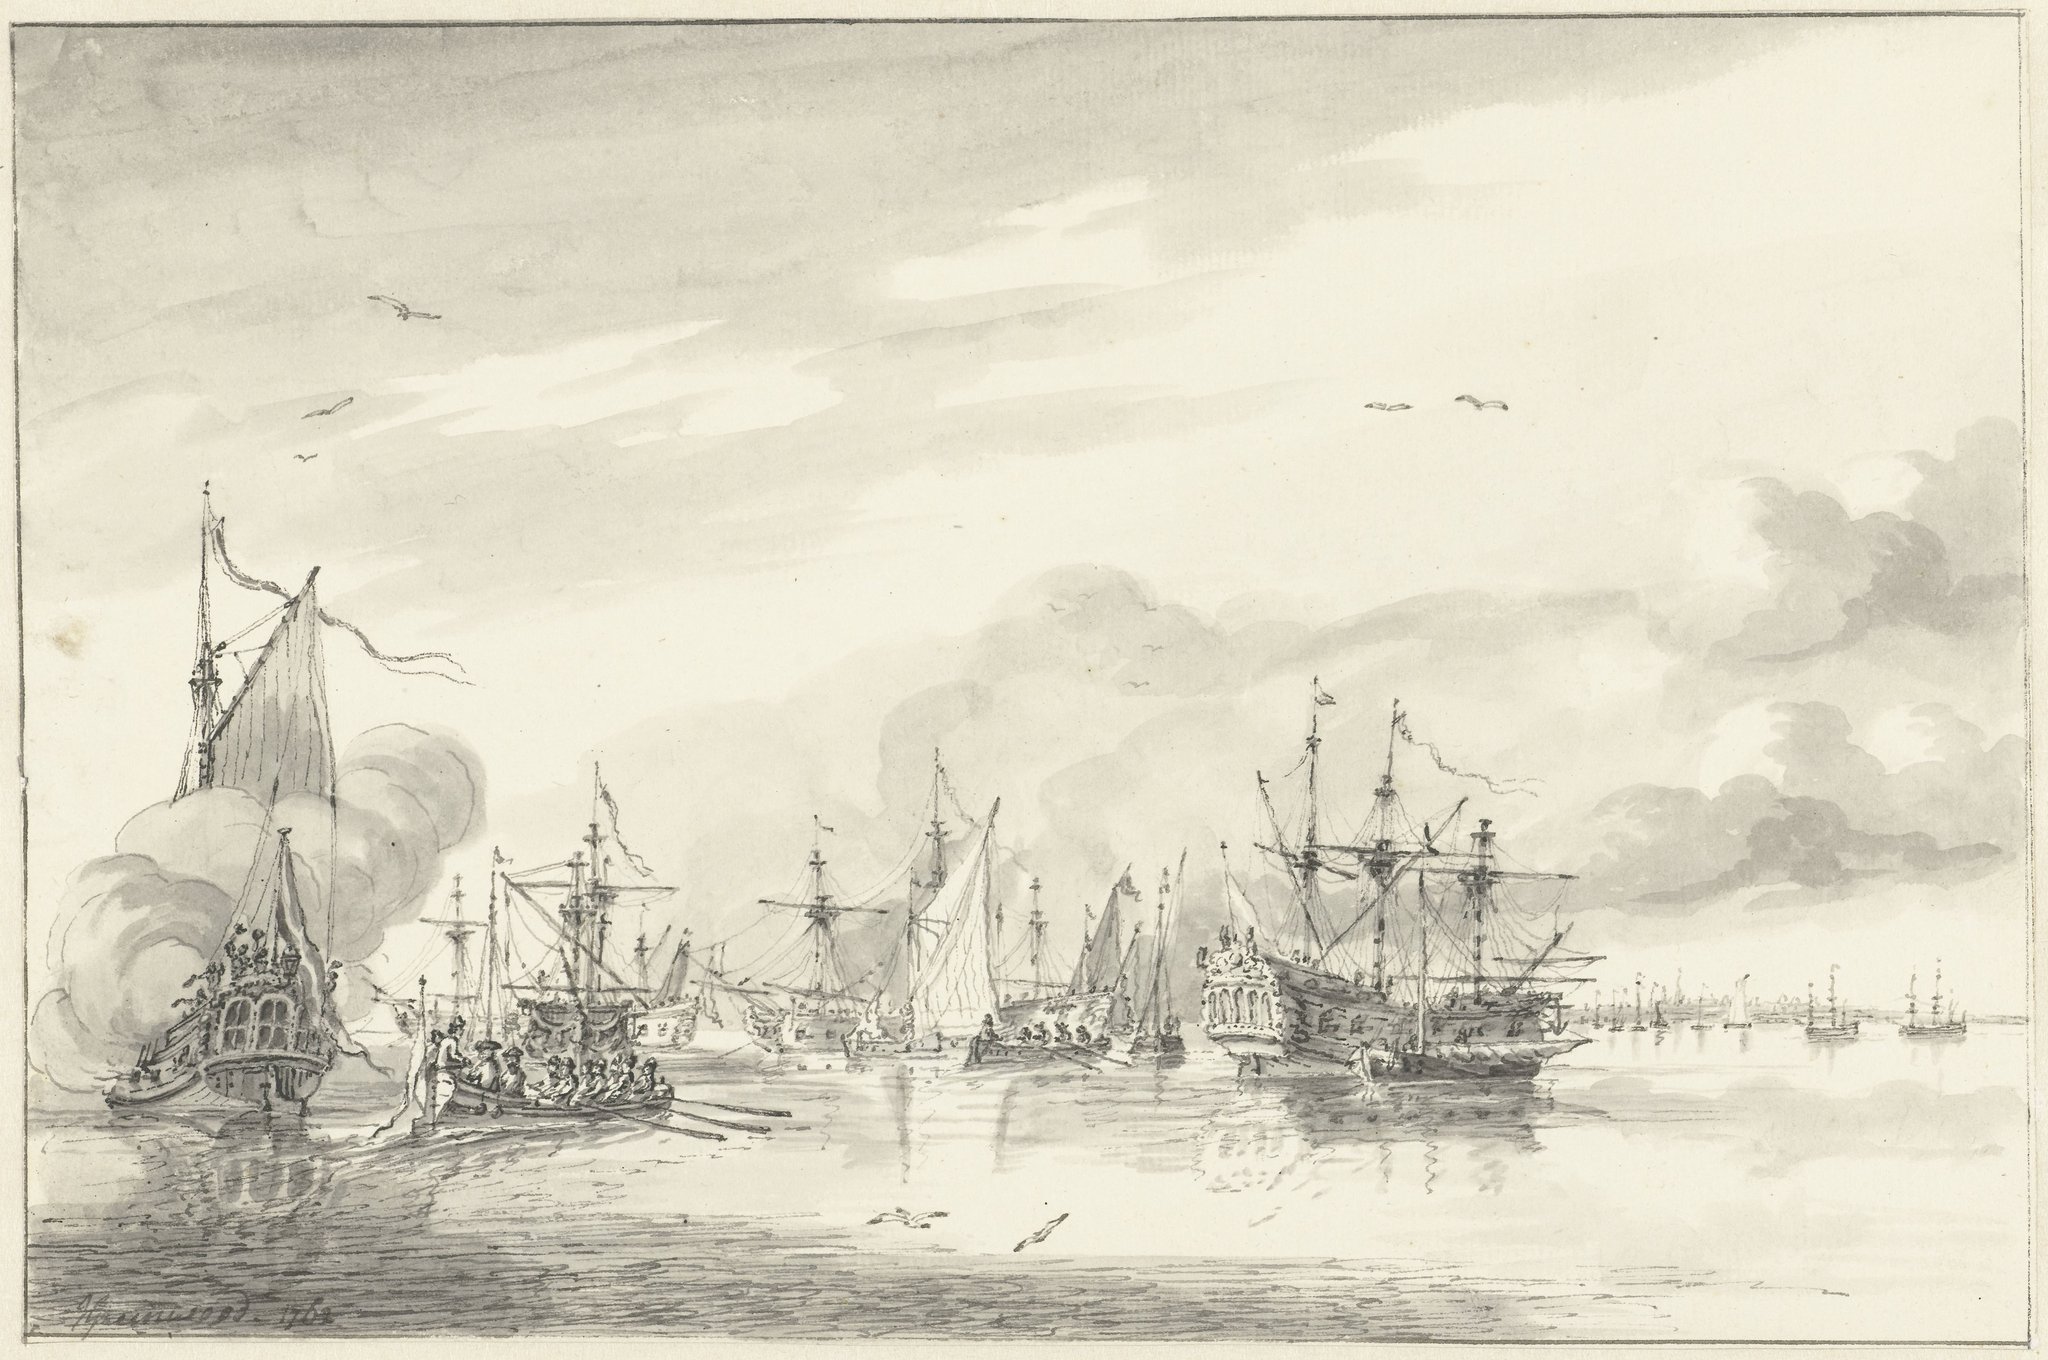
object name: drawing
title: Zeilschepen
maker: john greenwood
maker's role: auctioneer, draughtsman, print maker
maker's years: 1727-1792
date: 1762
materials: chalk, ink, paper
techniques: brush, pen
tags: sailing-ship, sailing-boat